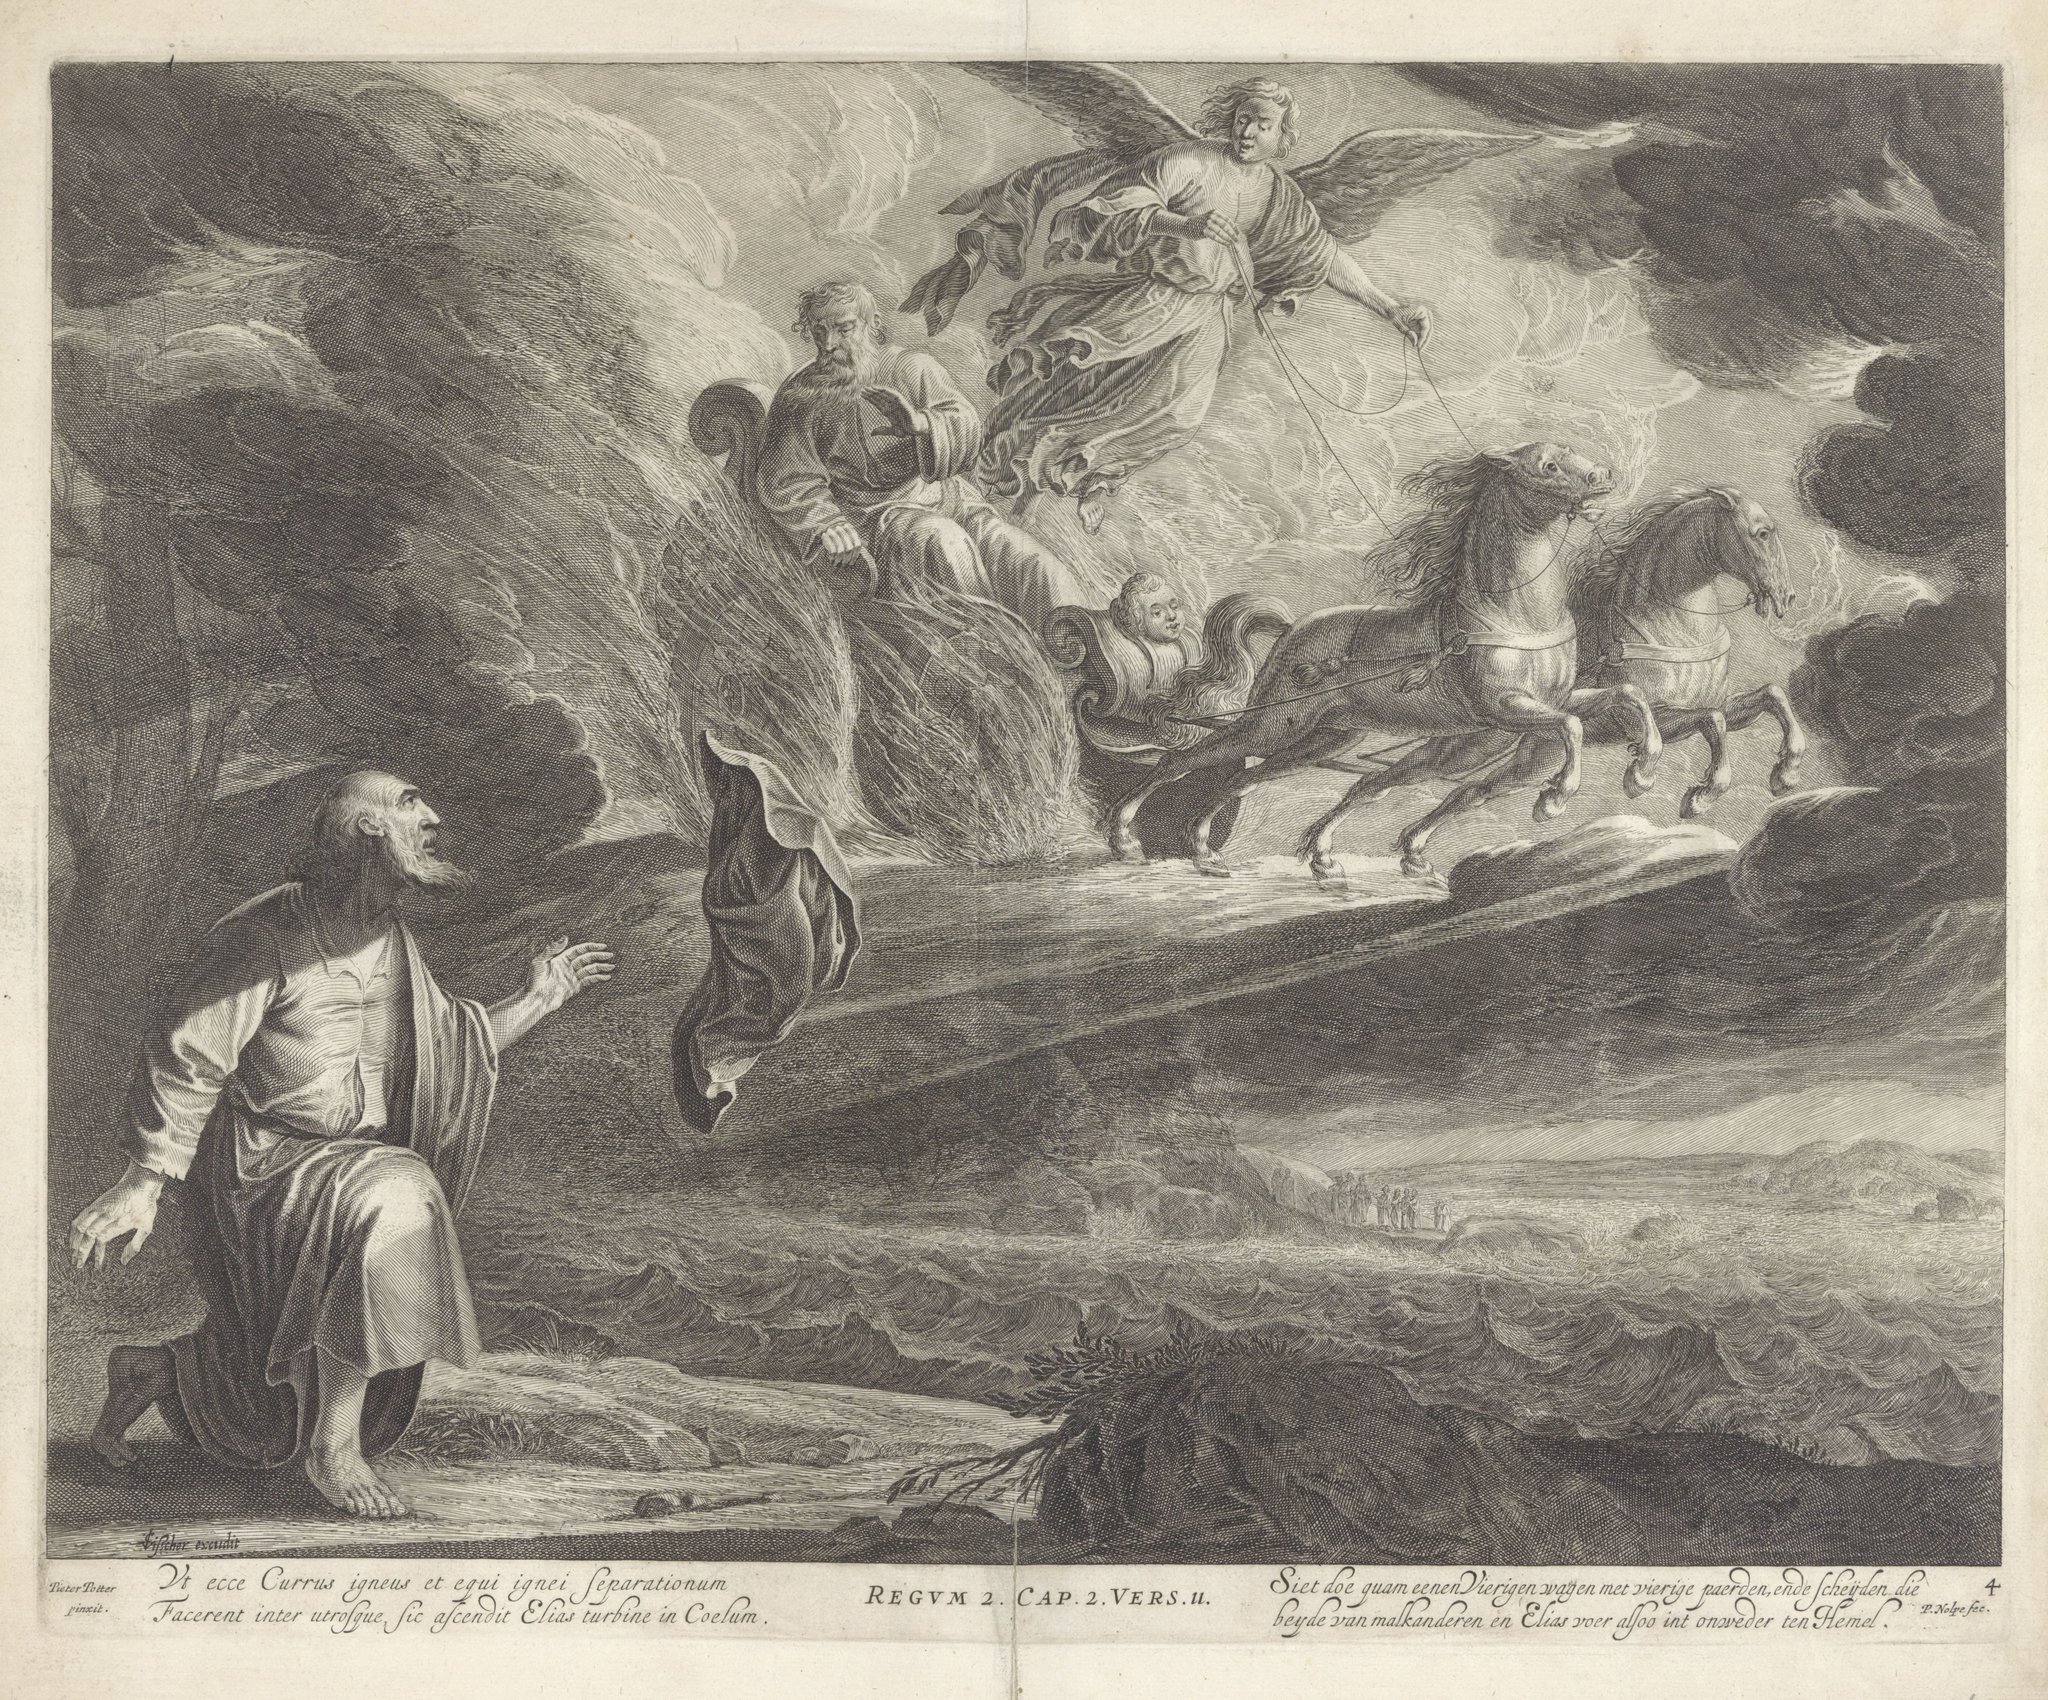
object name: print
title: Elia in de vurige wagen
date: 1623-1653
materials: paper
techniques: engraving, etching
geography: amsterdam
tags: a chariot, horses of fire and a whirlwind appear and elijah is carried up into heaven; elijah's cloak falls (or he hands it over to elisha)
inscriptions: collector's mark: Lugt 2228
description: Elia rijdt in een vurige wagen, getrokken door twee paarden en bestuurd door een engel, ten hemel. Hij steekt zijn hand op naar de achtergebleven profeet Elisa en zijn mantel valt uit de wagen naar beneden. Naar de Bijbeltekst in 2 Kon. 2:11. Onderaan in de marge twee tweeregelige teksten in het Latijn en het Nederlands. Rechtsonder genummerd: 4.